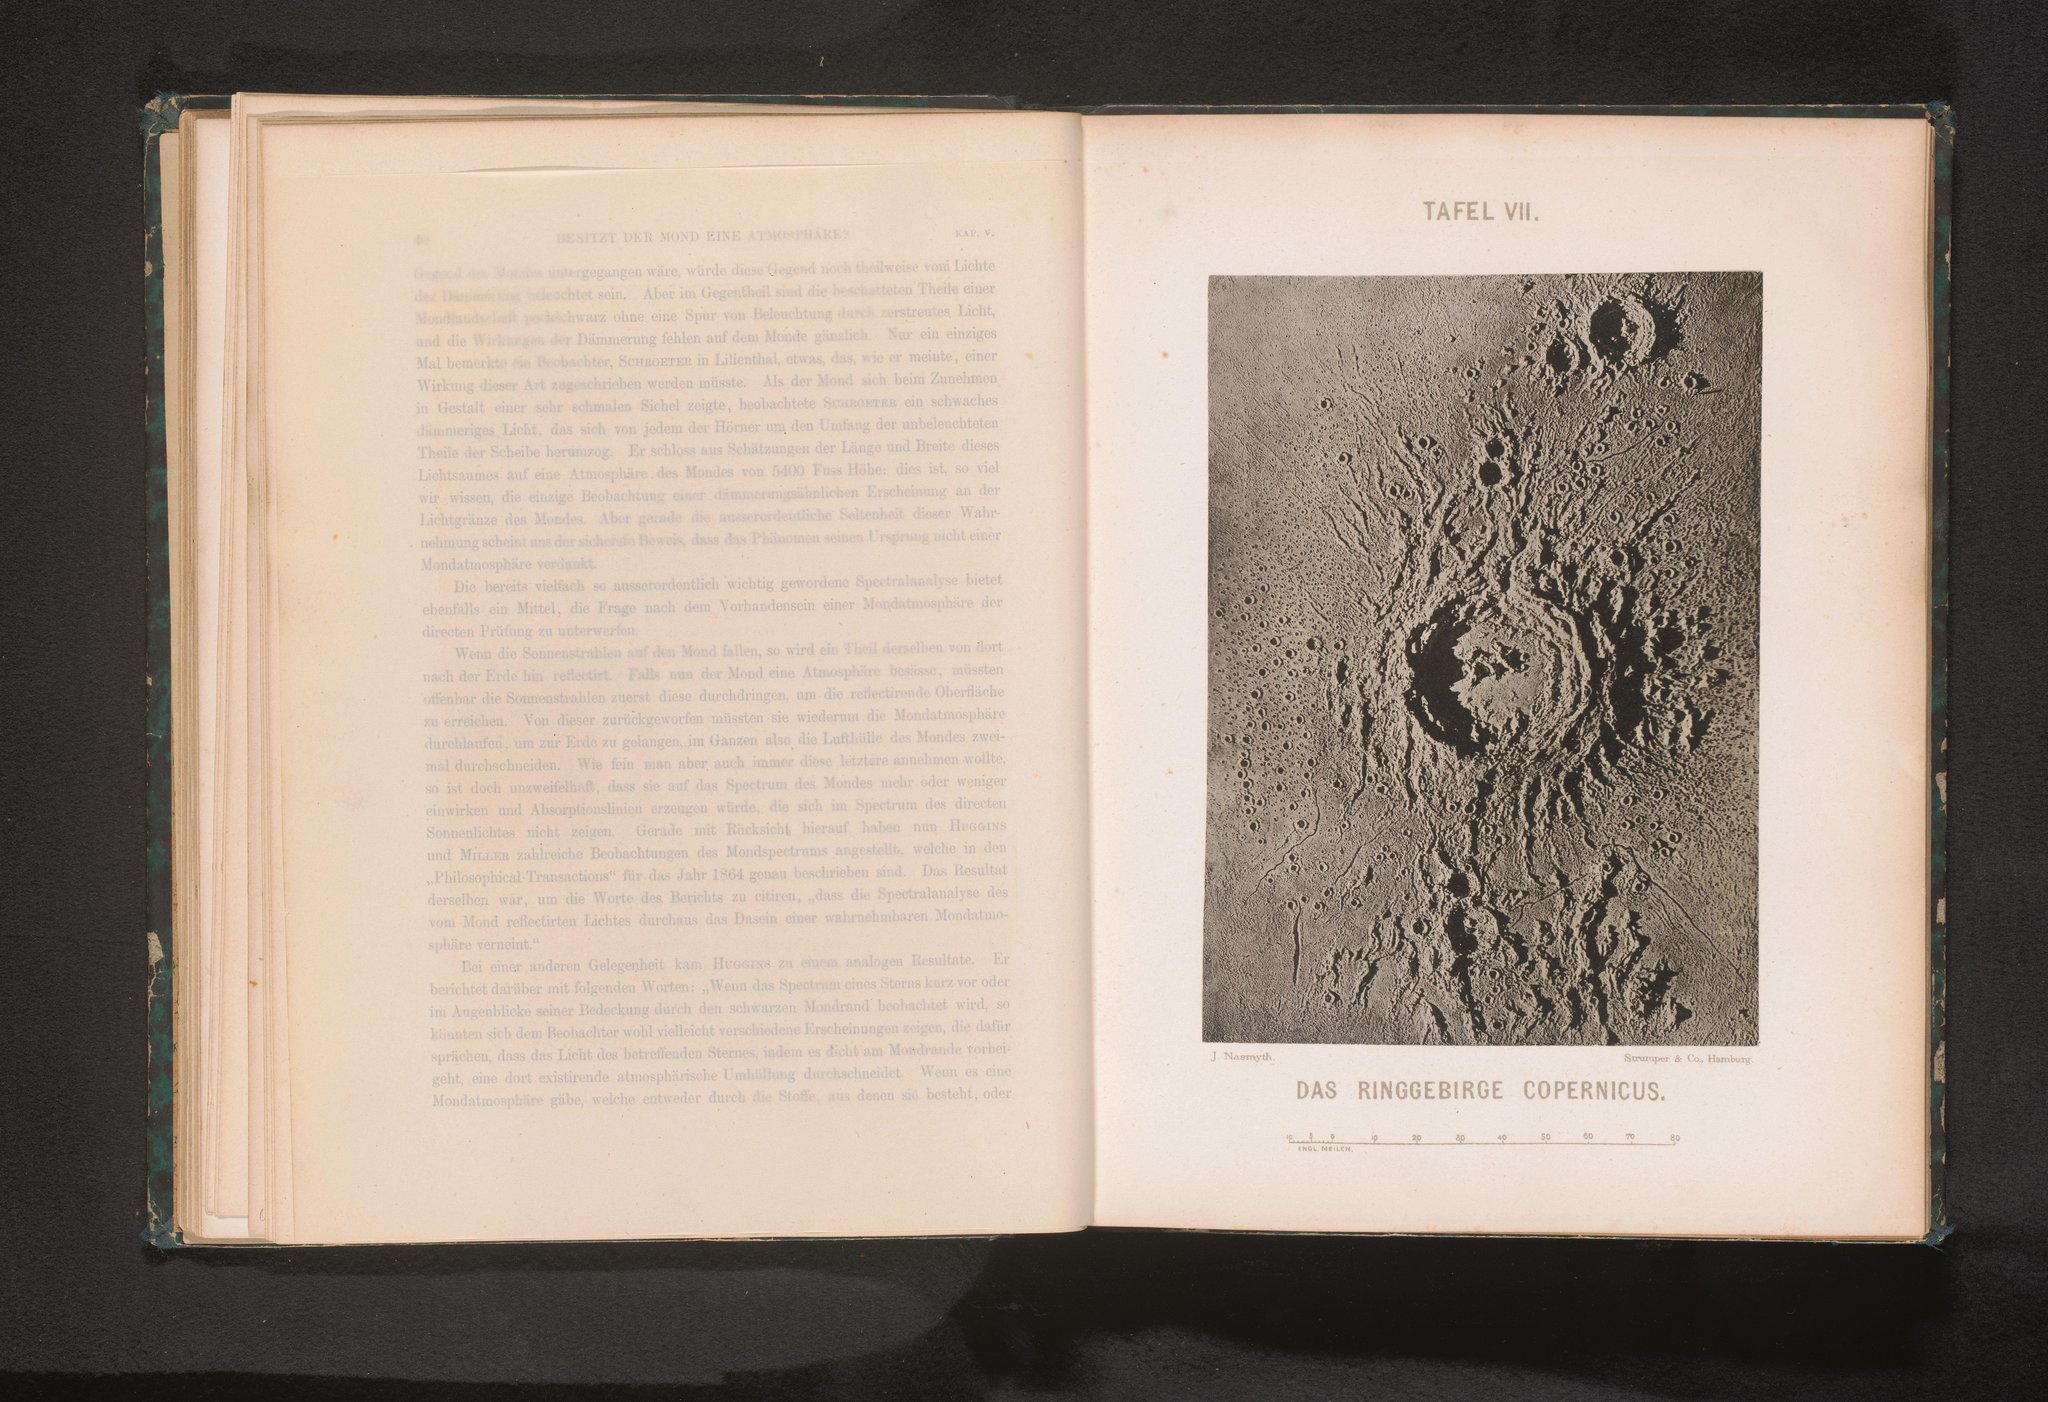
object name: photomechanical print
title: Gipsmodel van de maankrater Copernicus, van bovenaf gezien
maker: james nasmyth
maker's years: 1808-1890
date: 1863-1873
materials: paper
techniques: photograph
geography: hamburg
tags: surface of the moon, moon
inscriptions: number: ‘Tafel VII.’